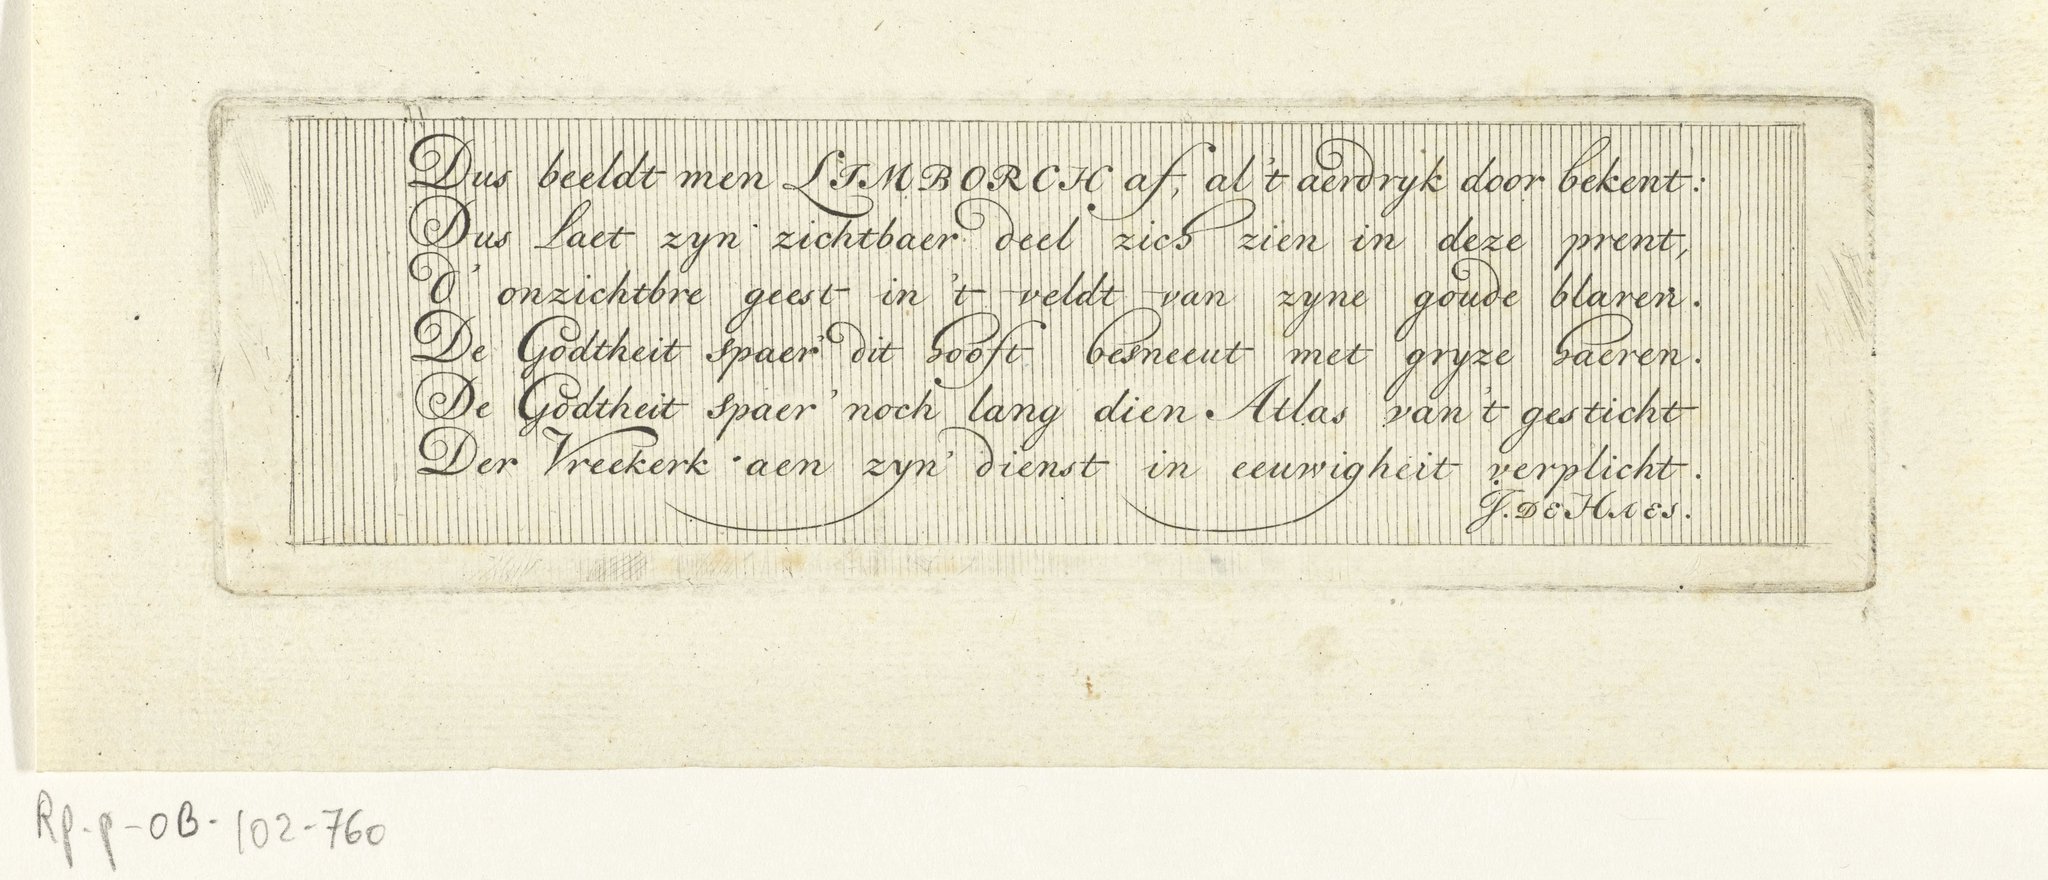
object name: print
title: Lofdicht op een portret van Philippus van Limborch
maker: joan de haes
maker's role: dichter, koopman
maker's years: 1685-1723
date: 1711-1713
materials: paper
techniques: engraving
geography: rotterdam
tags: amsterdam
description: Waarschijnlijk kon dit gedicht apart gedrukt worden bij het portret van Philippus van Limborch door Pieter van Gunst, zie bijvoorbeeld RP-P-2021-3132. Deze prent werd eerst, met het Latijnse gedicht van C. Brandt, gebruikt in: Limborch, Philippus van. Commentarius in Acta Apostolorum et in Epistolas Ad Romanos et ad Hebraeos. Rotterdam: Barent Bos, 1711. De prent is waarschijnlijk met het Nederlandse gedicht van Joan de Haes gebruikt in de Nederlandse vertaling: Limborch, Philippus van. Uitleggingen over de Handelingen der Apostelen. Rotterdam: Barent Bos, 1713.